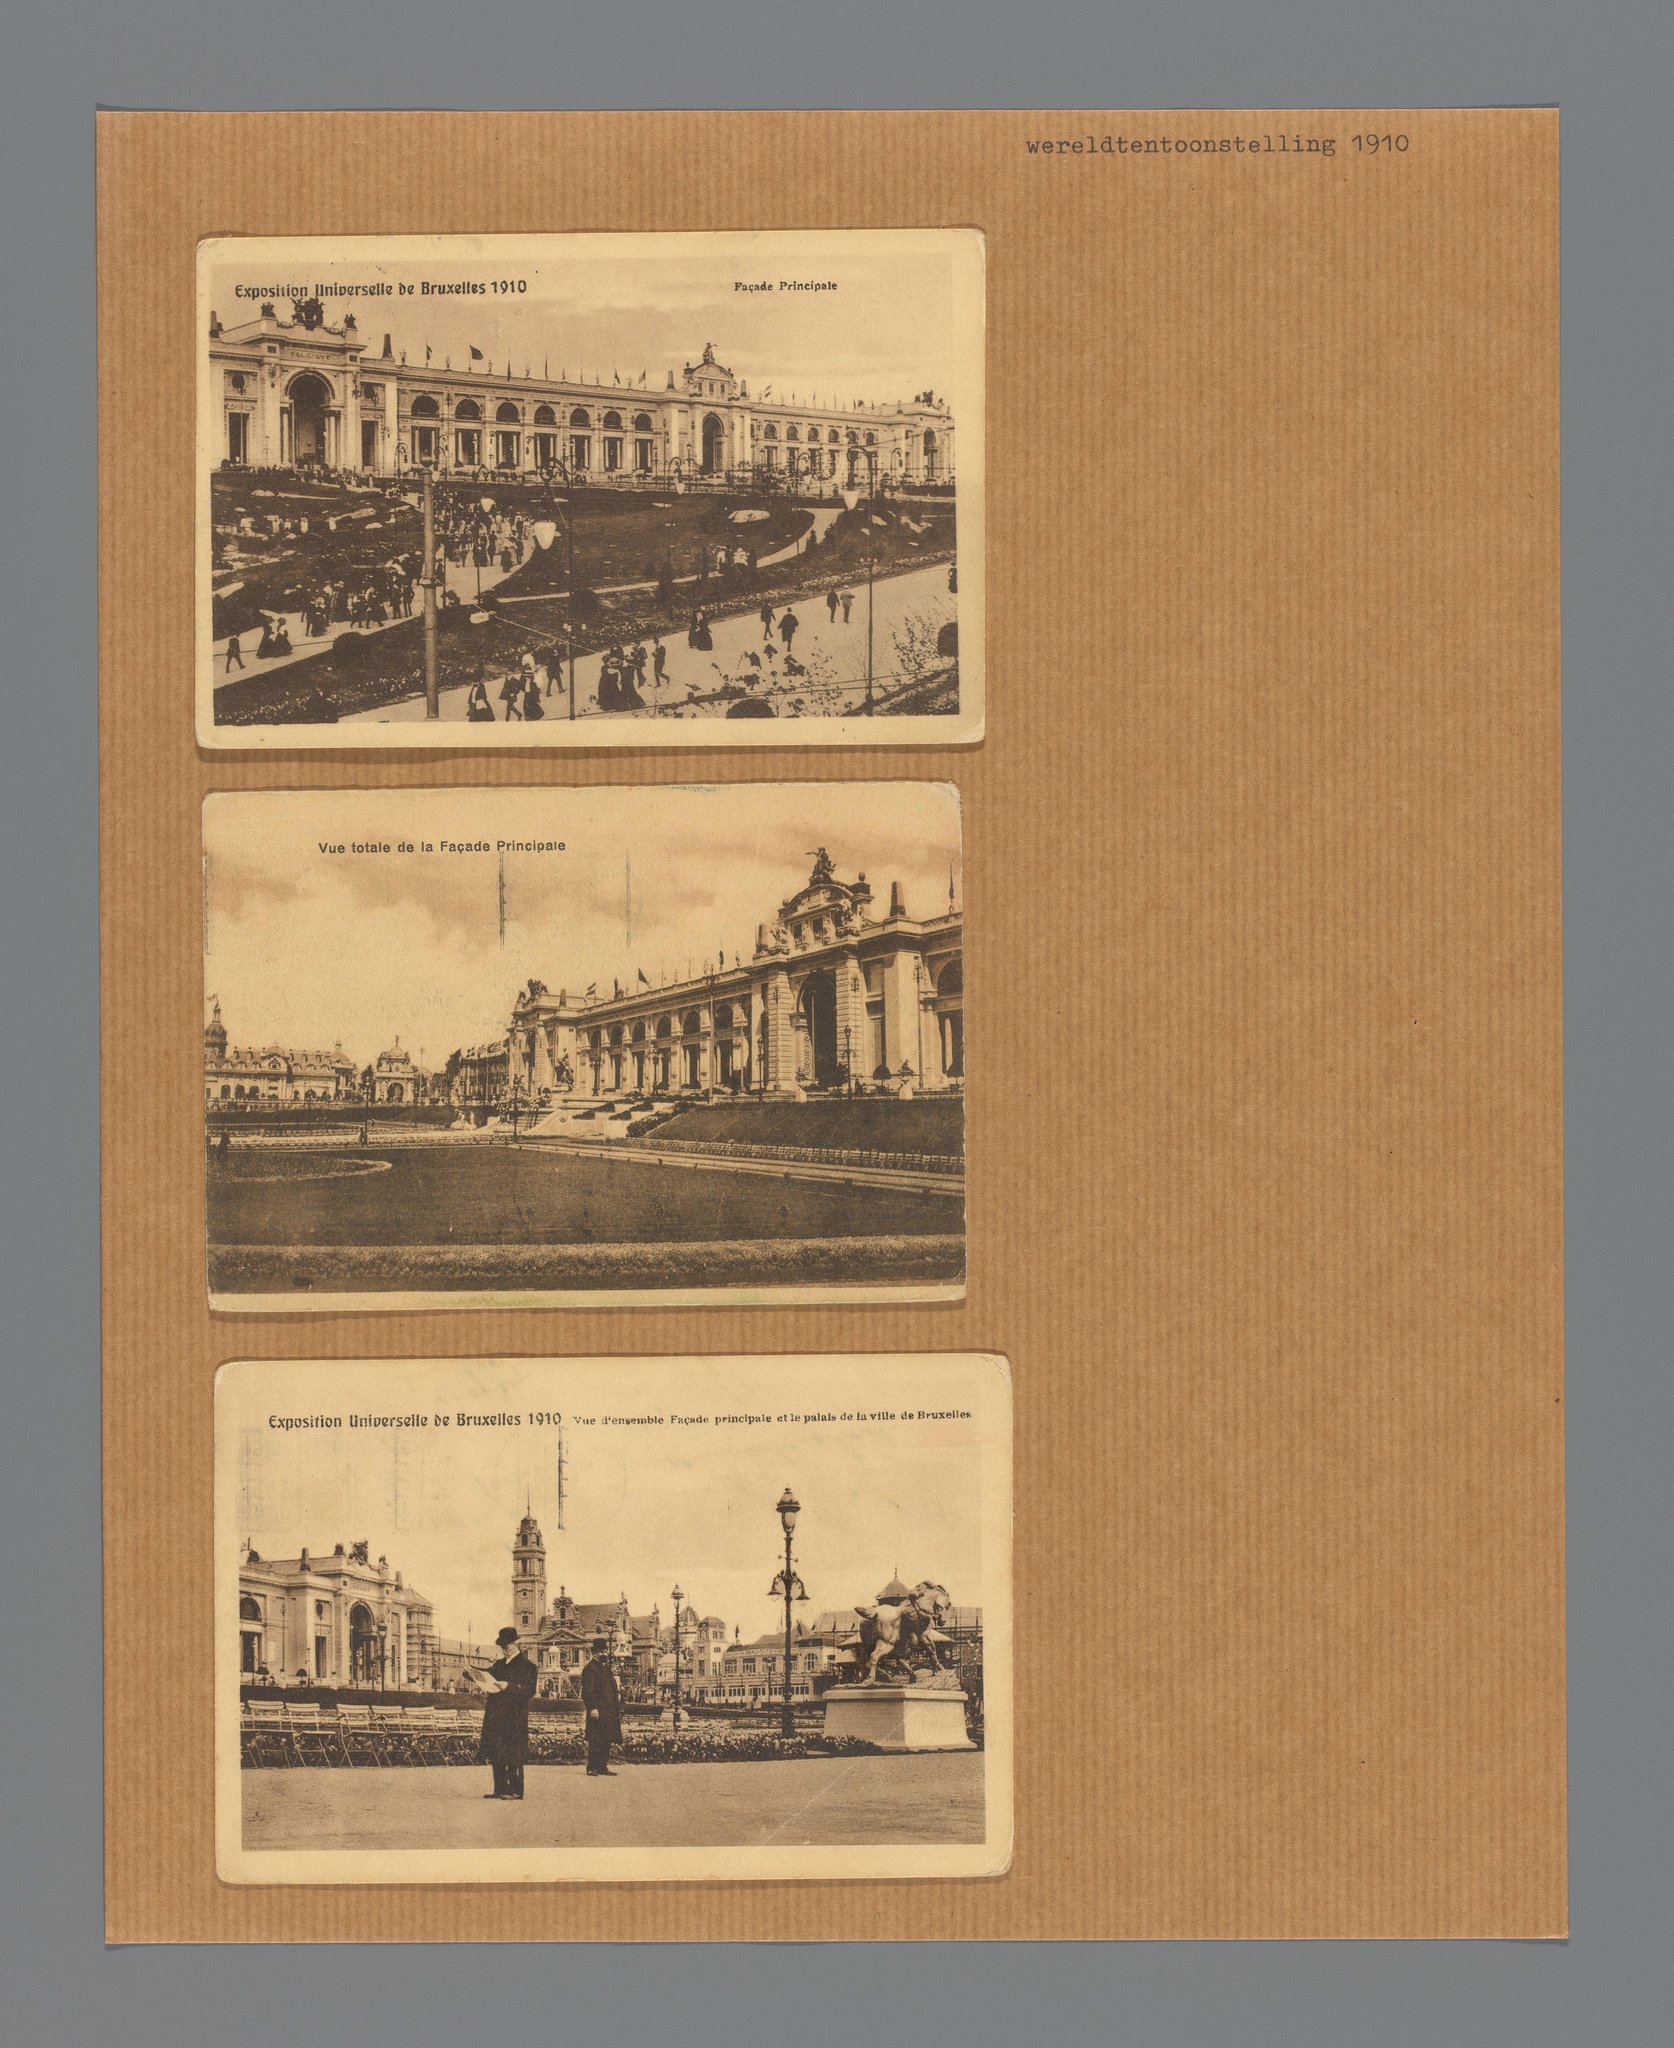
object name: photograph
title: Wereldtentoonstelling Brussels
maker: Anonymous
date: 1910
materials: photographic support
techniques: photograph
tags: brussels